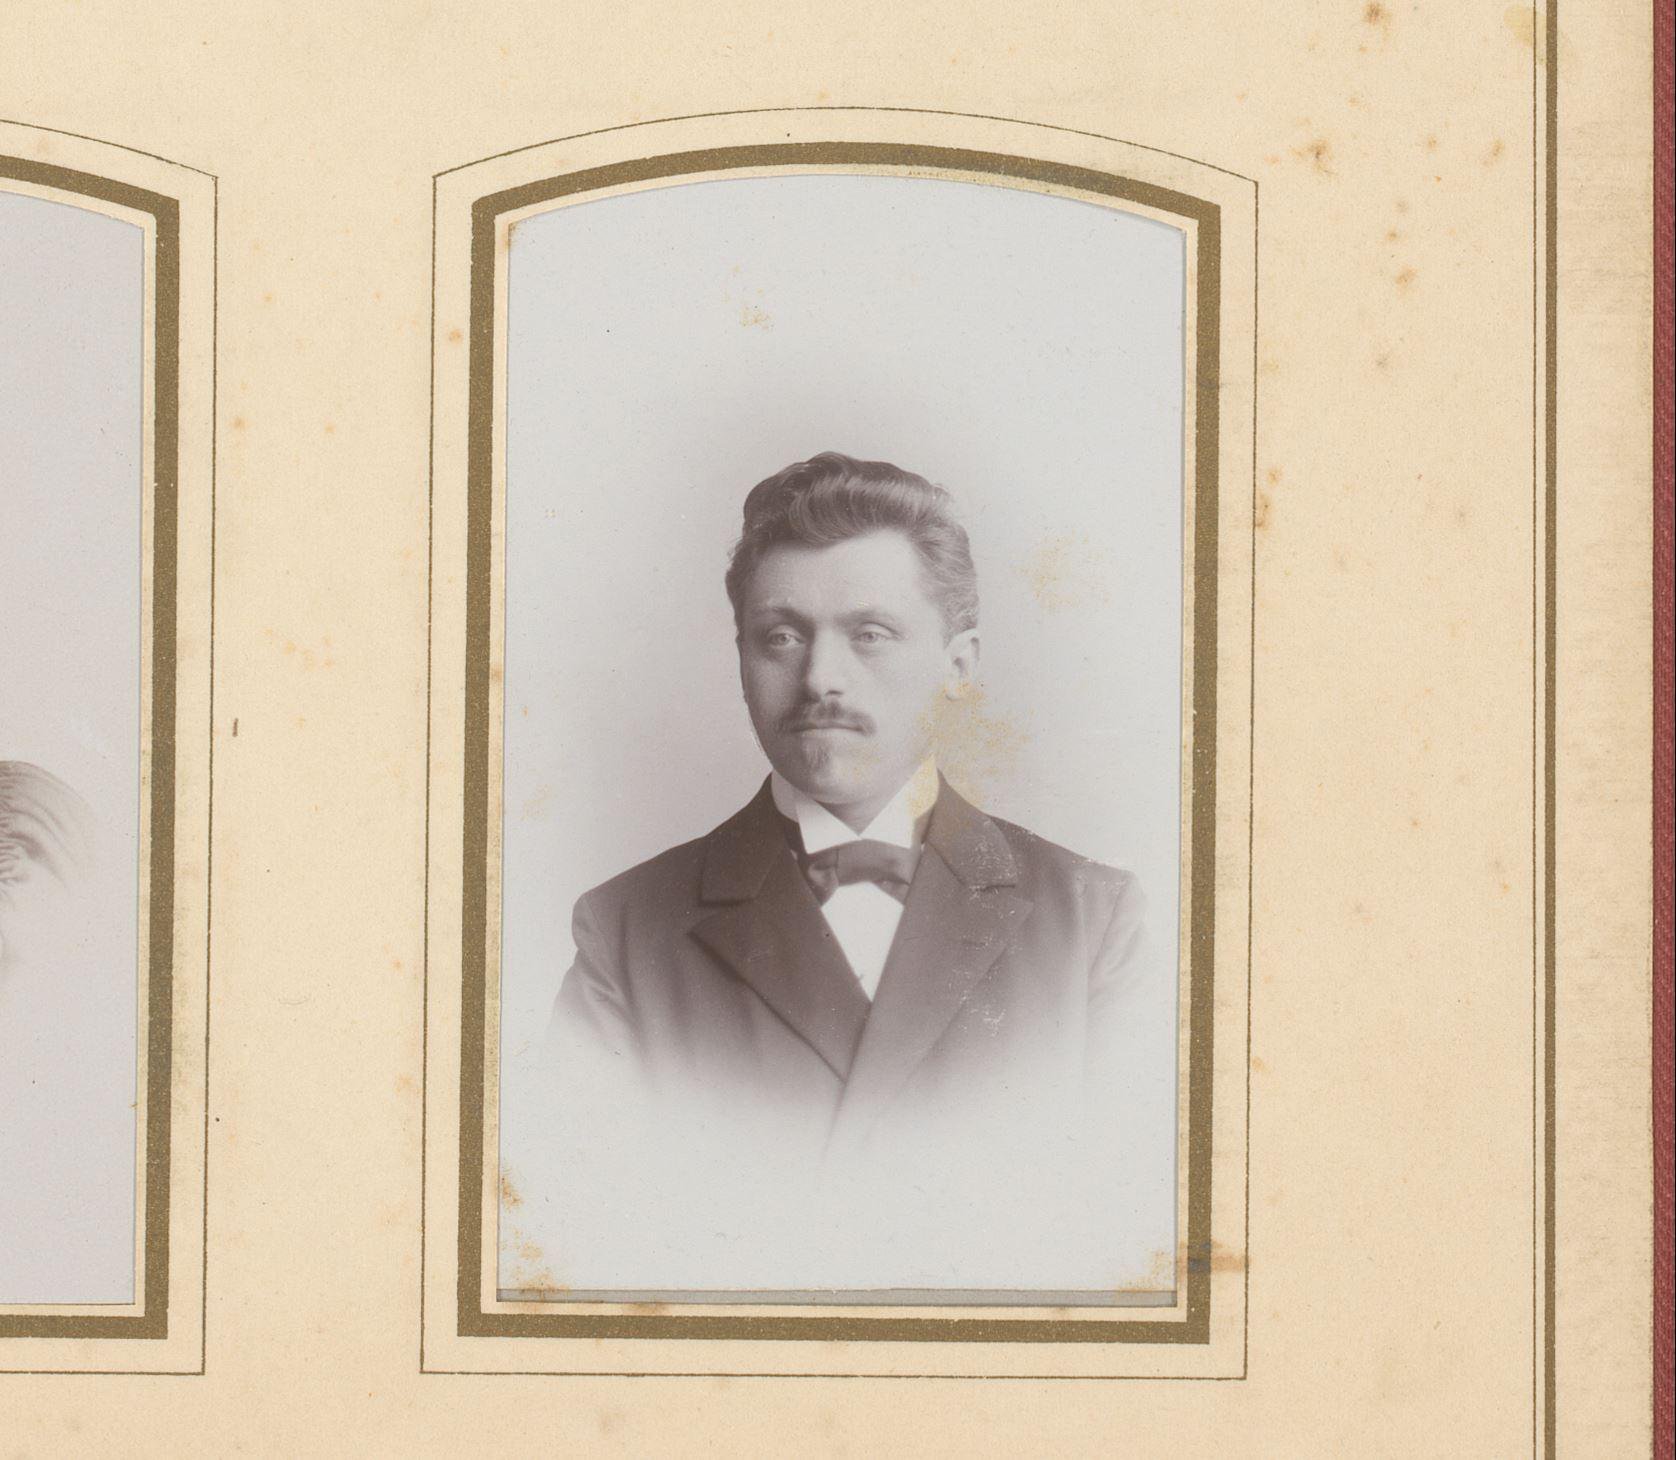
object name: photograph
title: Portret van een man met snor en vlinderstrik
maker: willem bernard bekkering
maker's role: painter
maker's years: 1858-1902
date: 1886-1902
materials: cardboard, photographic support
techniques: collodion silver print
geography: groningen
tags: moustache, historical persons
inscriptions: inscription: ‘W. B. Bekkering/ Firma Godfried de Jong/ Groningen/ Heerestraat.’